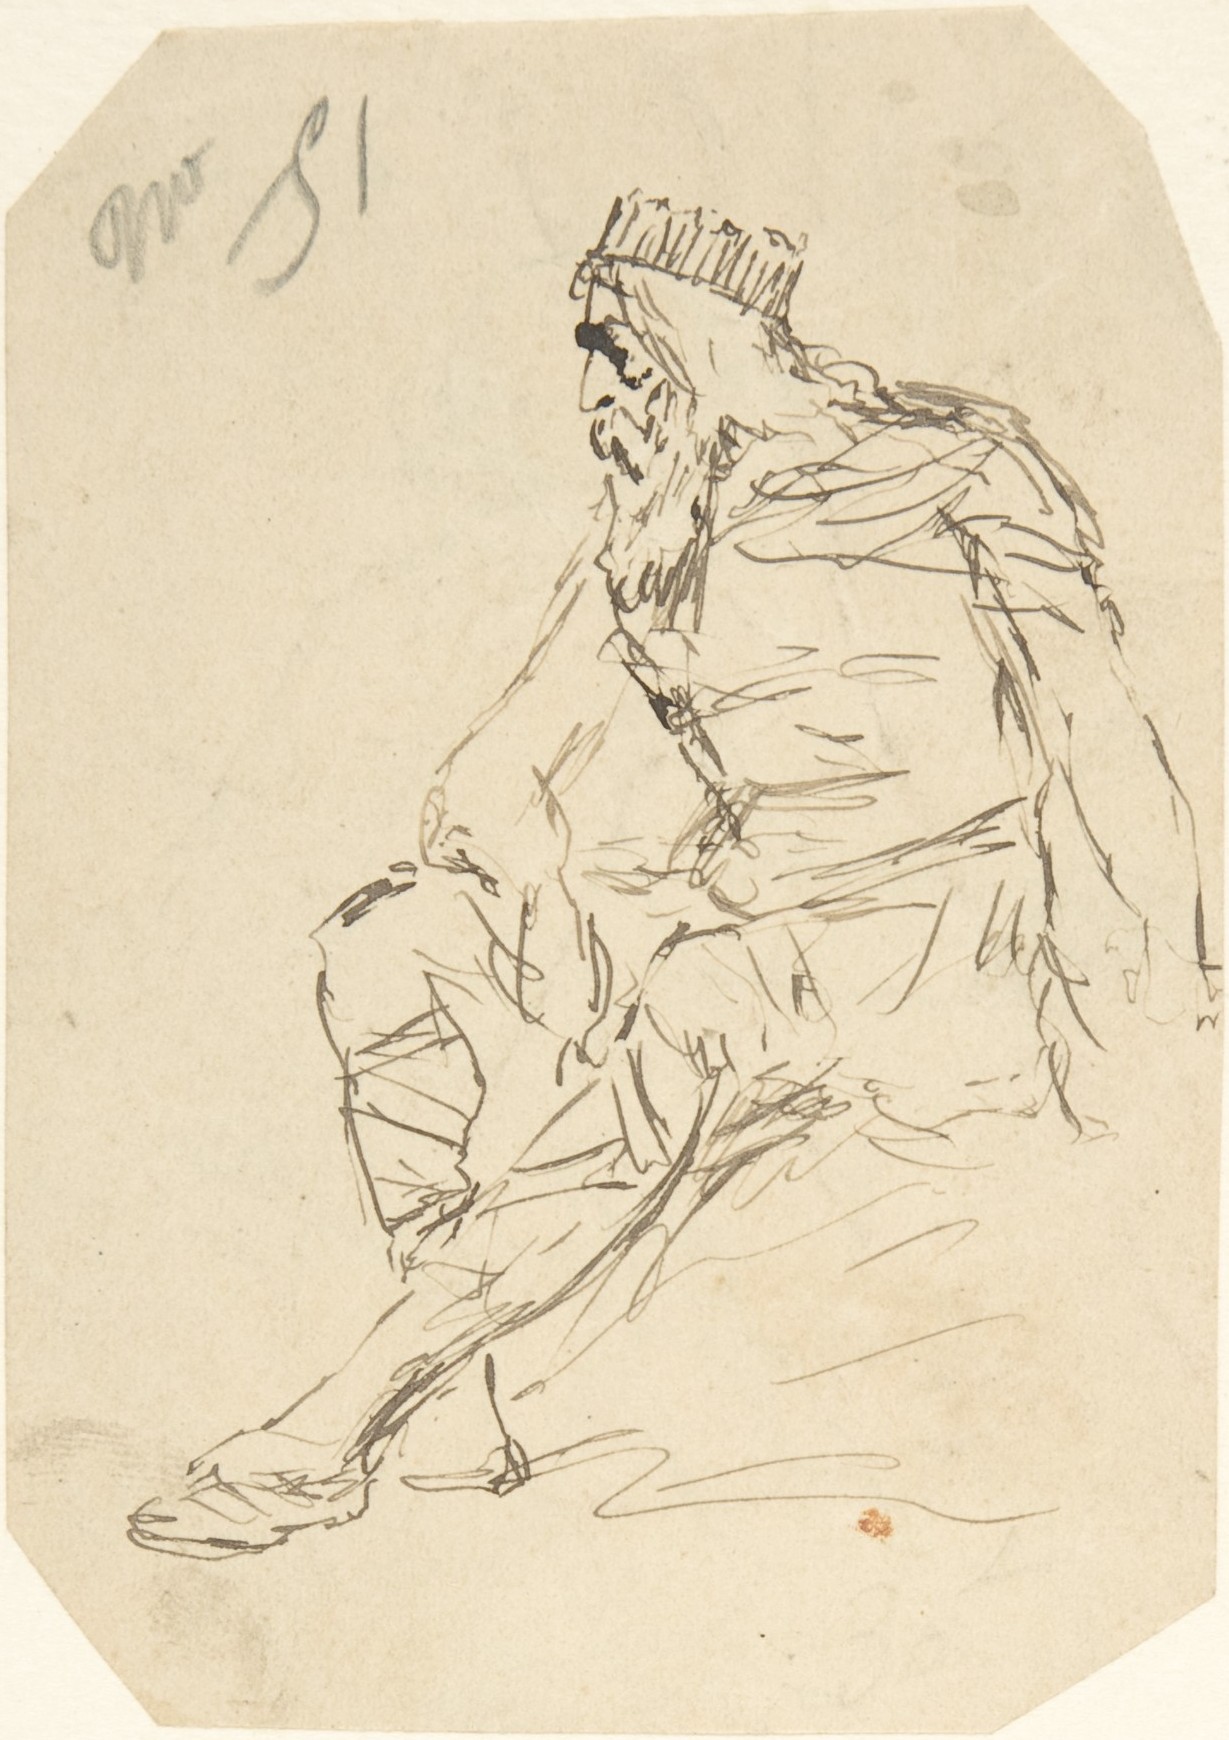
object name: drawing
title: Study of a King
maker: rodolphe bresdin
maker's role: artist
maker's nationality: french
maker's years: 1822-1885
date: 1822-1885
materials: ink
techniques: pen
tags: kings